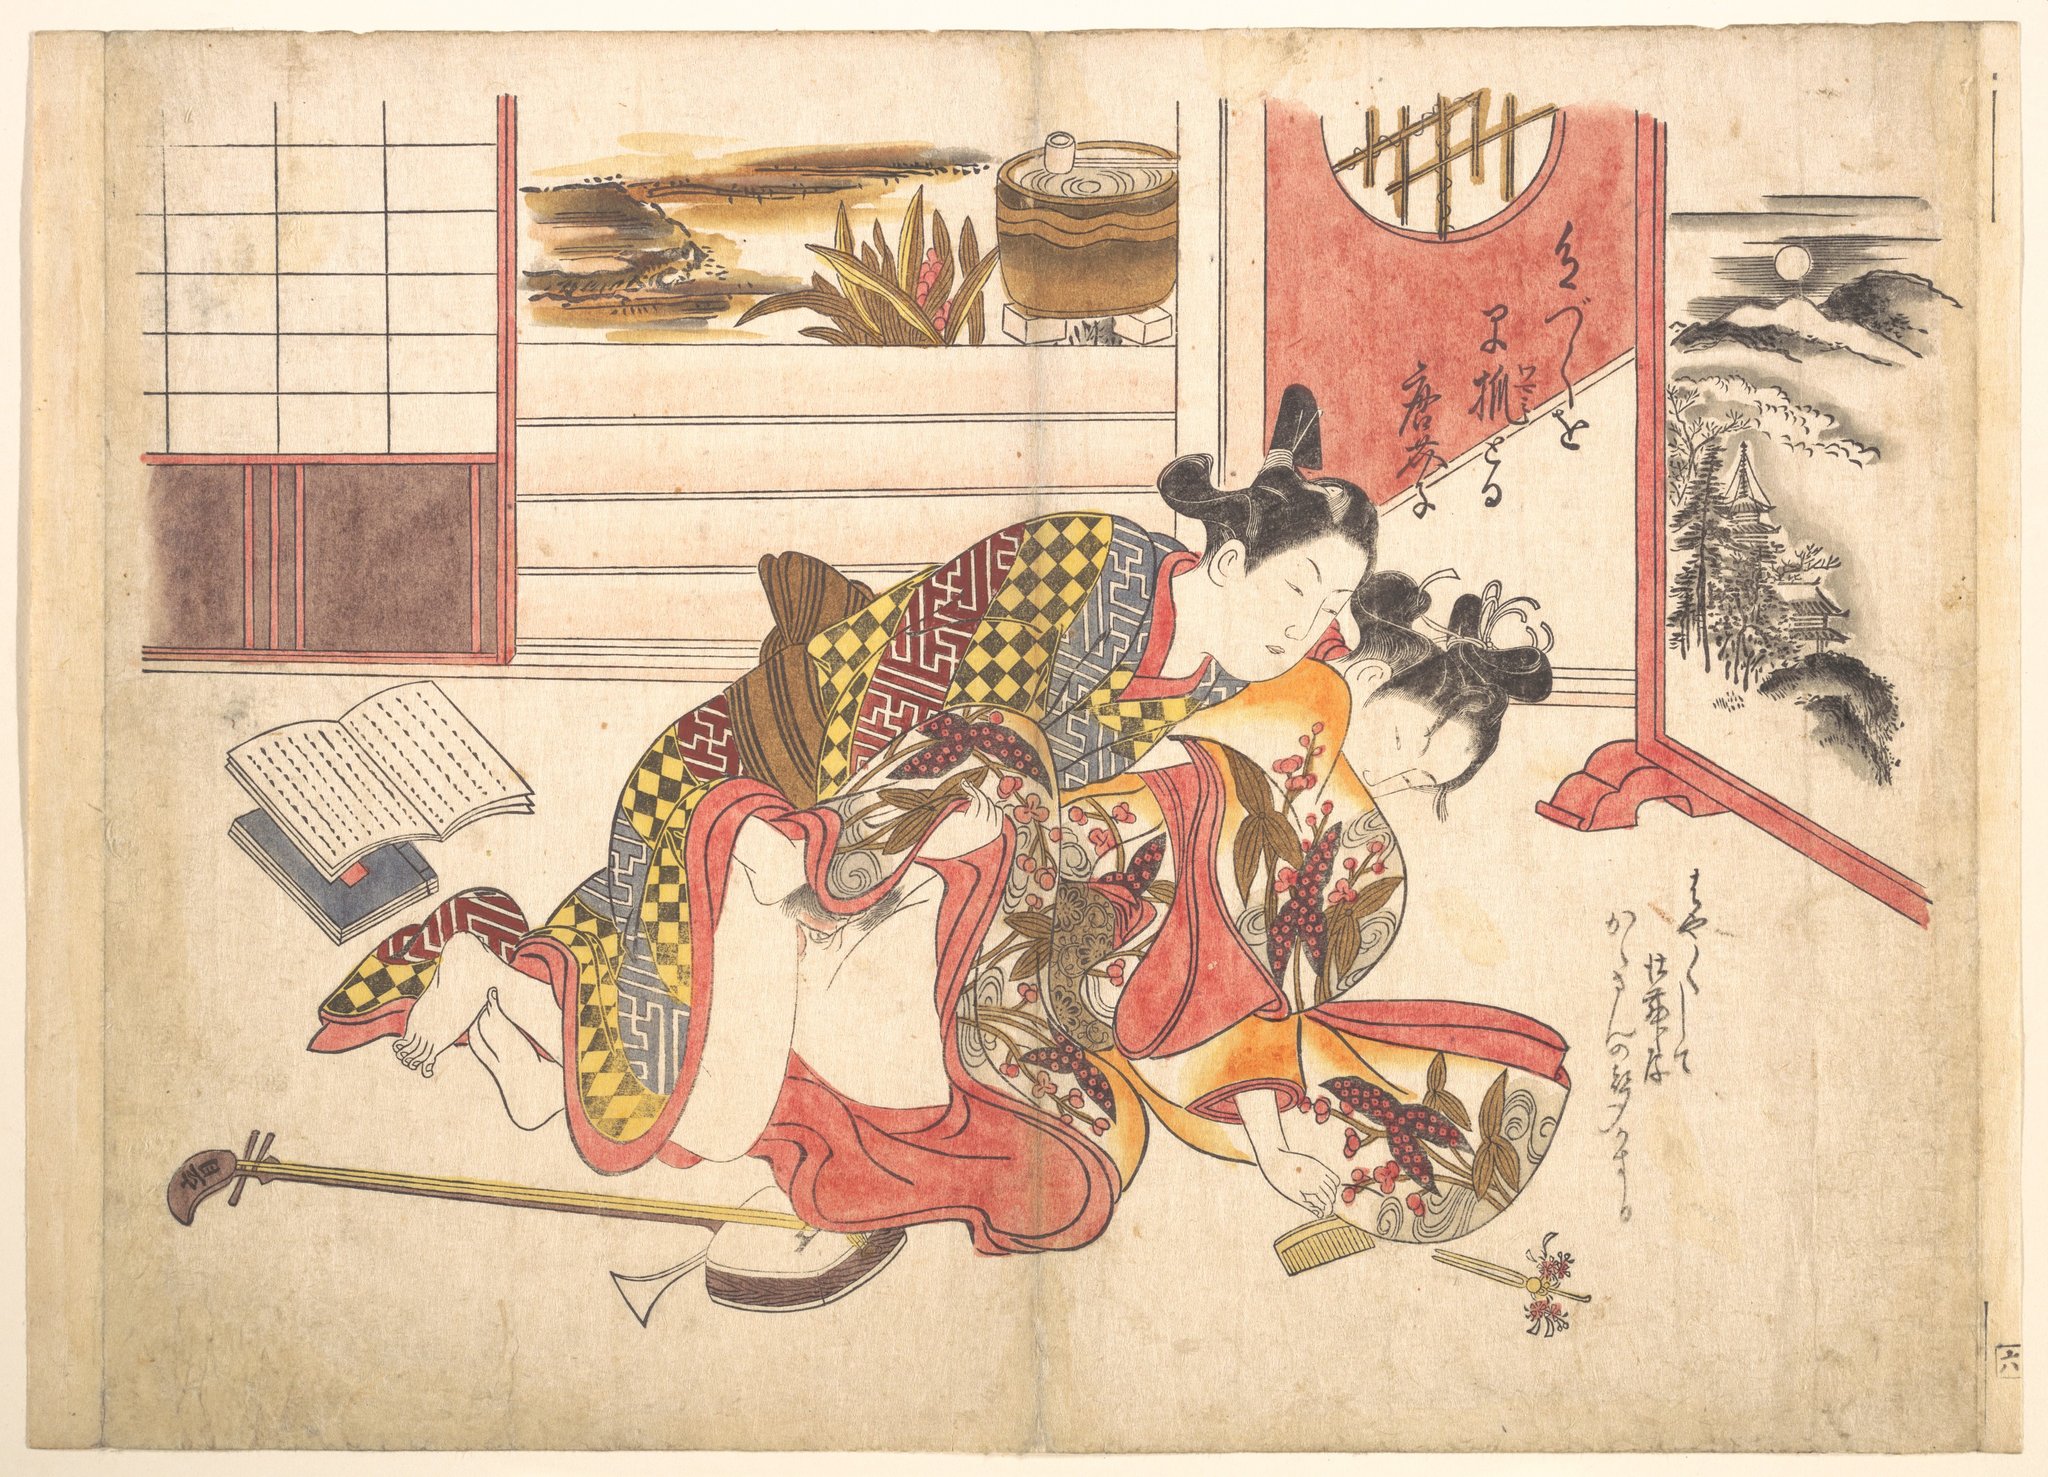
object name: print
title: Bedroom Scene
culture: japanese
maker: okumura masanobu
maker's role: artist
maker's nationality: japanese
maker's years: 1686-1764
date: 1739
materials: ink, paper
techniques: hand coloring, woodblock print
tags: bedrooms,men,women